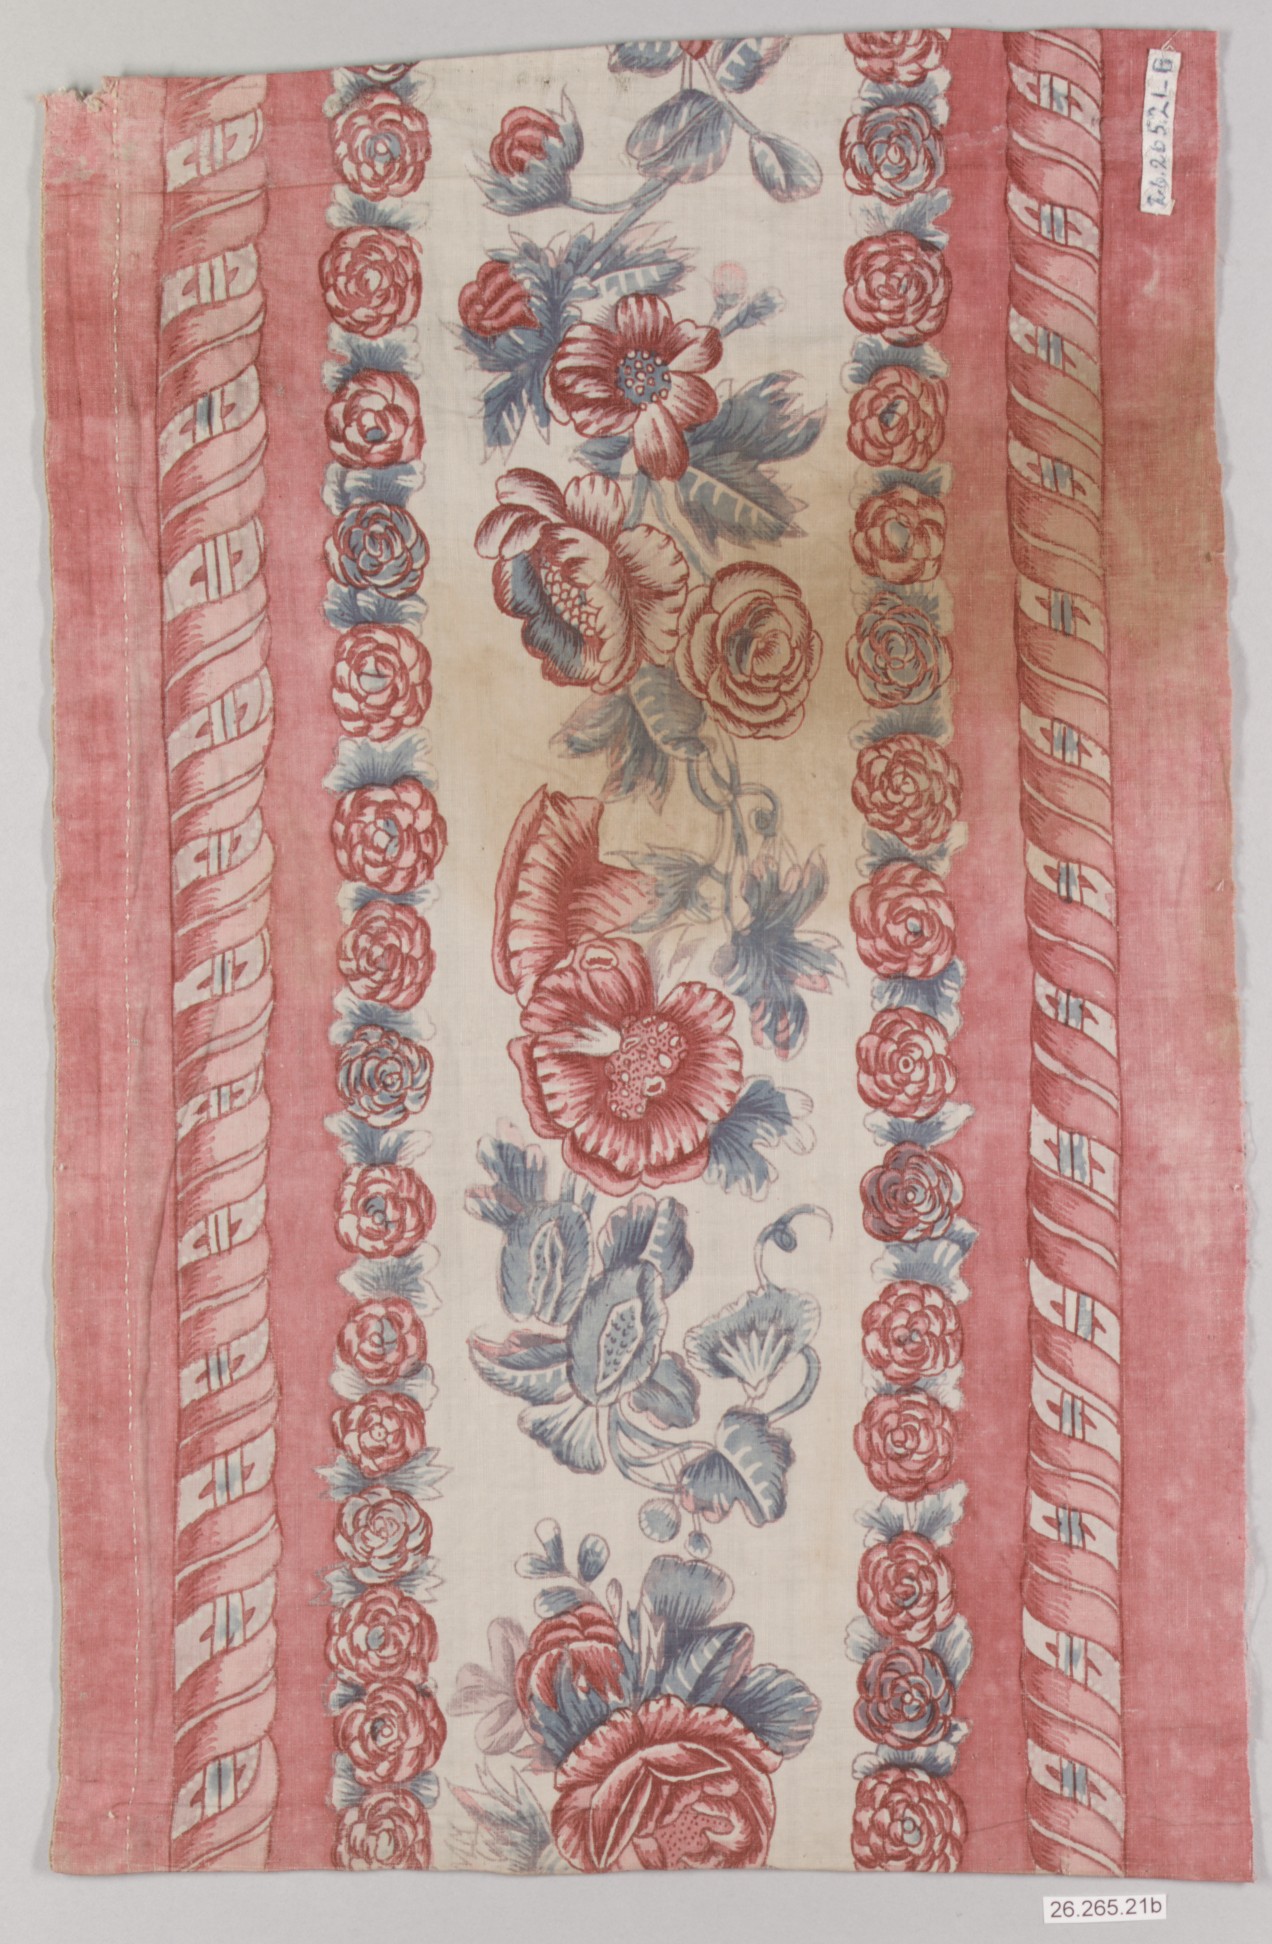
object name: piece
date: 1801-1900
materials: cotton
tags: flowers,leaves